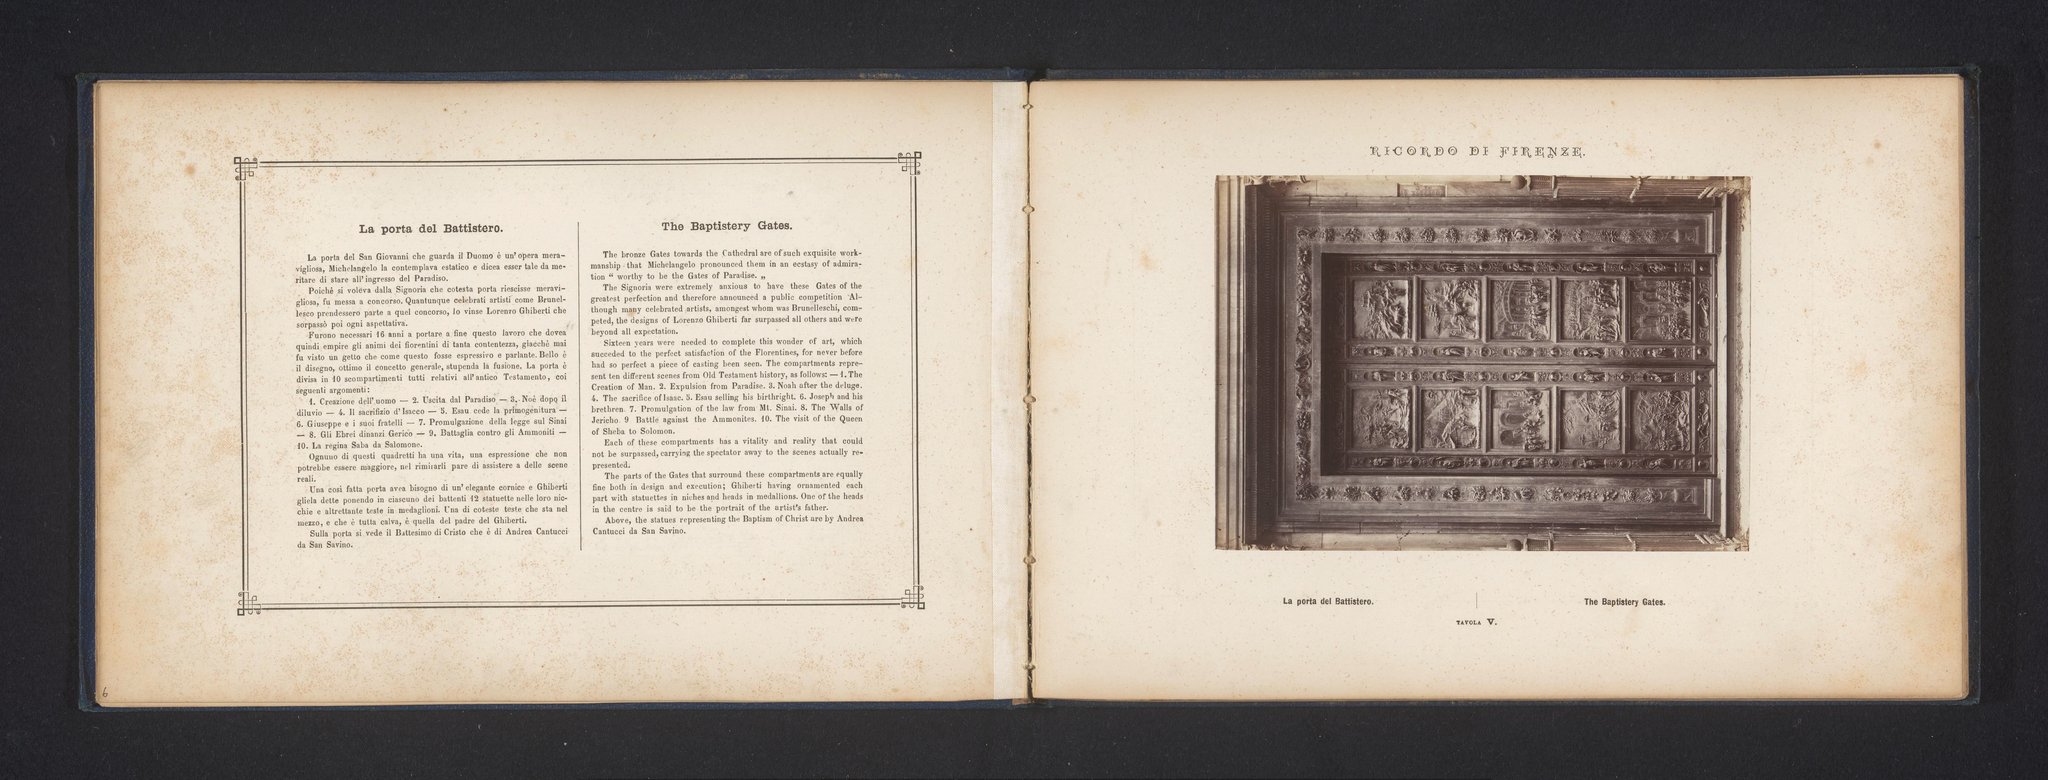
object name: page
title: Deur van het Baptisterium in Florence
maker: giacomo brogi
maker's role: fotograaf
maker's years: 1822-1881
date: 1861-1871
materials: photographic support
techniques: albumen print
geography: florence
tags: church (exterior), gate, entrance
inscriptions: number: ‘Tavola V.’